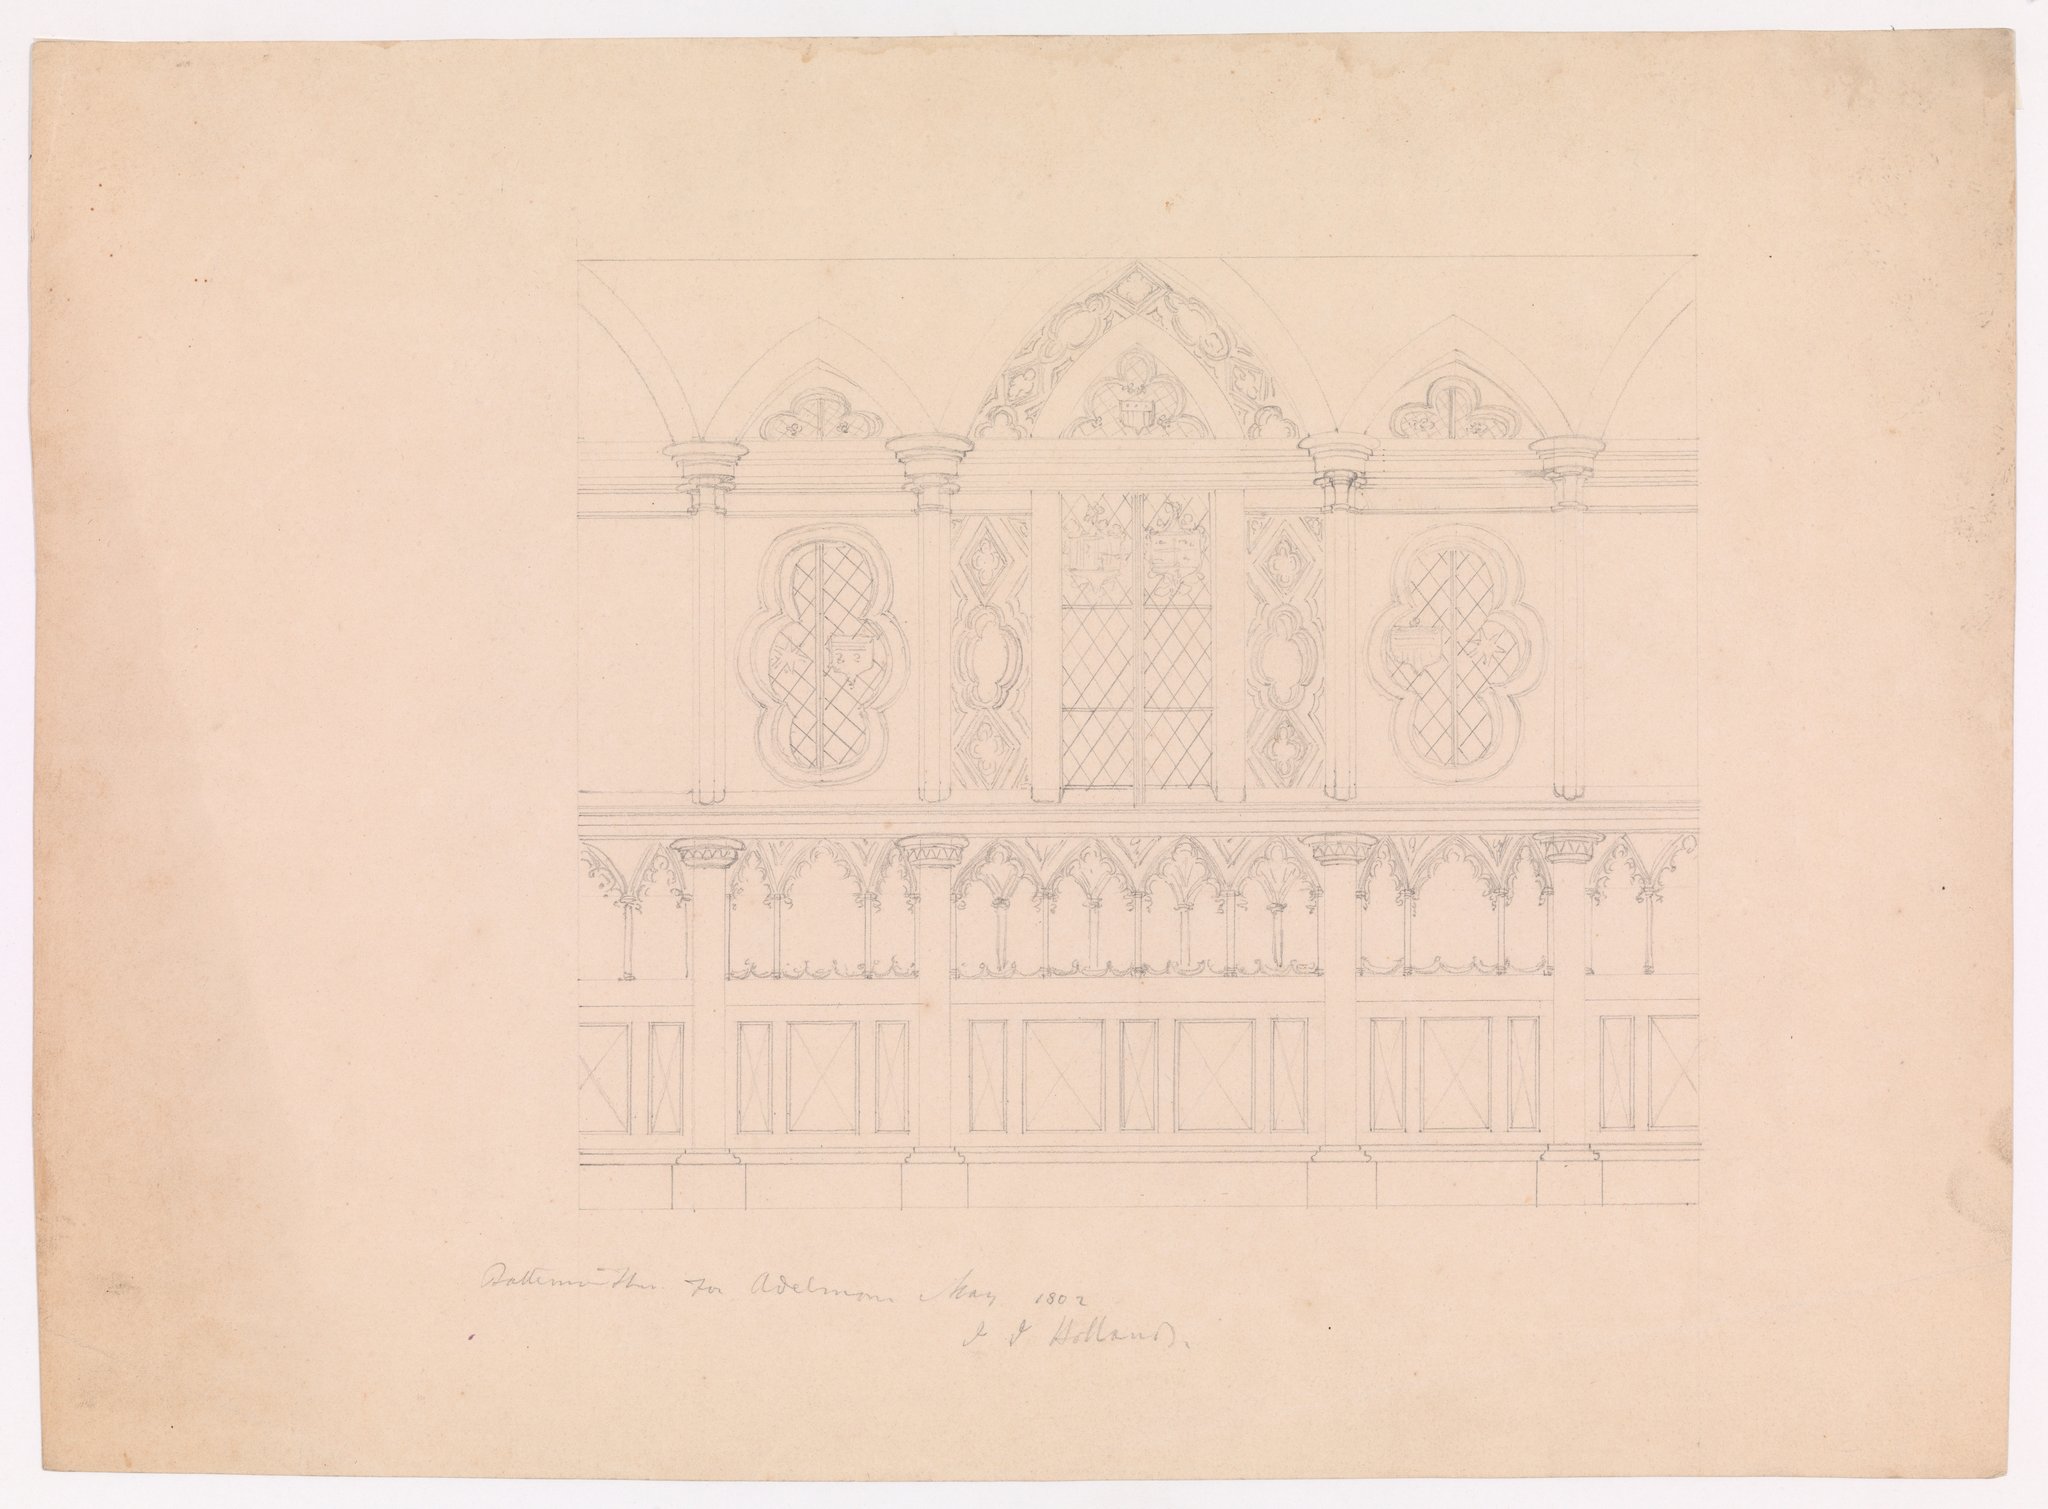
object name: drawing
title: Design for a Side Chapel in the Gothic Style, for Adelmorn the Outlaw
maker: john joseph holland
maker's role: artist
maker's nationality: american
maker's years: 1776-1820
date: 1802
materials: graphite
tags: architecture,chapels